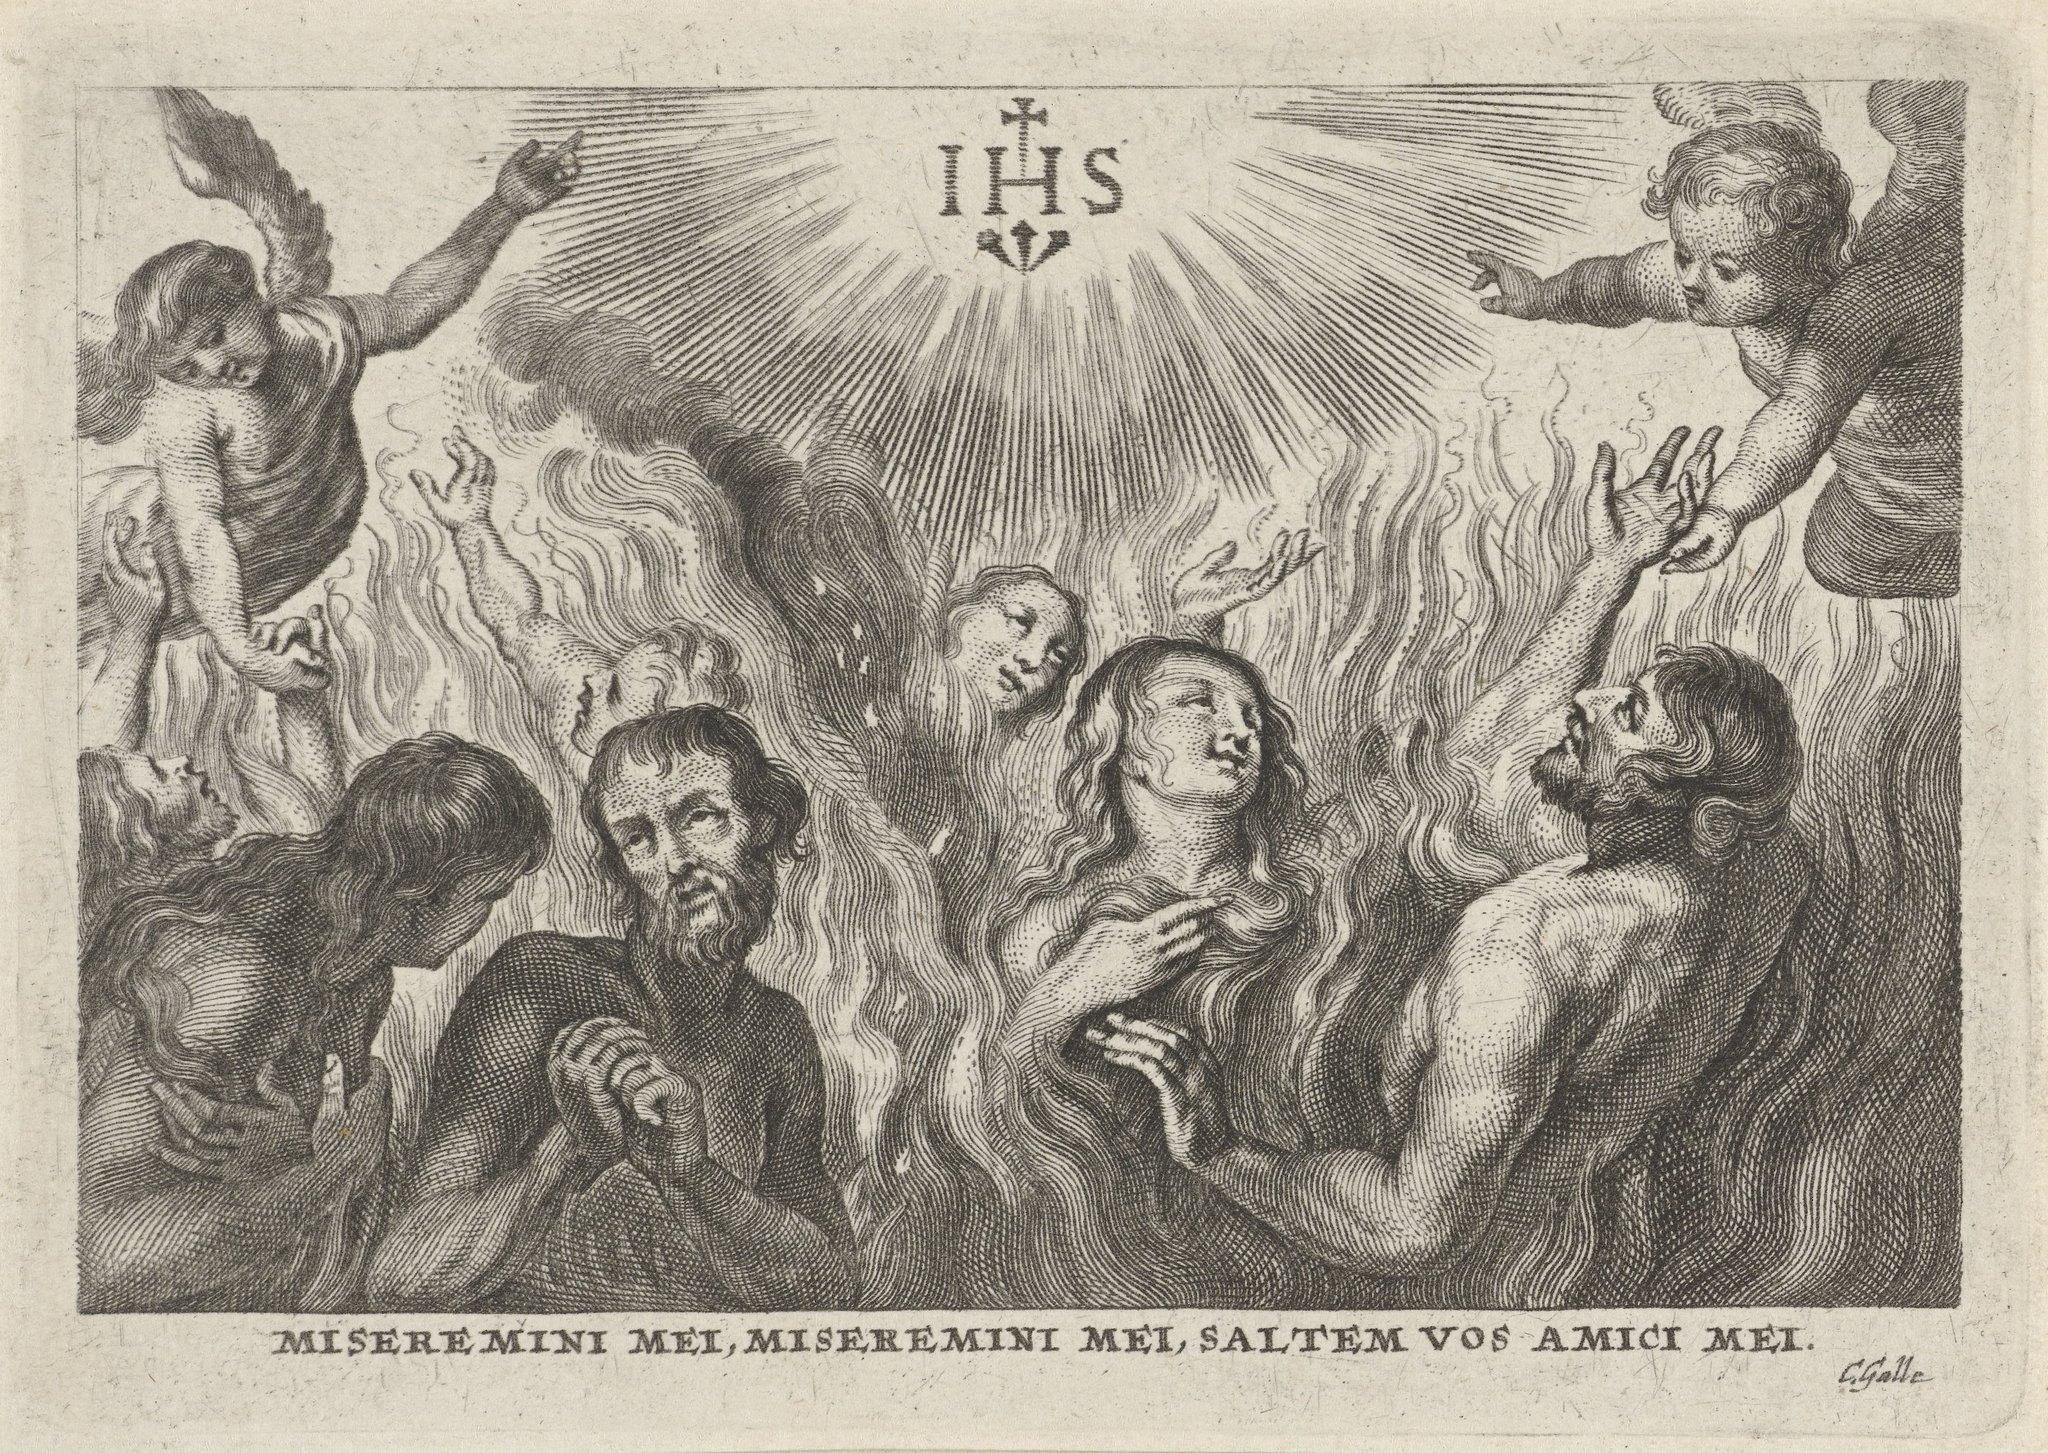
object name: print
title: Mensen in het vagevuur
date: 1600-1699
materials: paper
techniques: engraving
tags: ihs ('iesus hominum salvator') ~ symbol of christ, representations of hell (with the damned and devils), usually with burning fires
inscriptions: collector's mark: Lugt 240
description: Een groepje mensen gaat op in de vlammenzee van het vagevuur. Een engel redt een van hen en trekt hem aan zijn arm uit het vuur omhoog. In het midden het Christusmonogram IHS in een stralende zon.